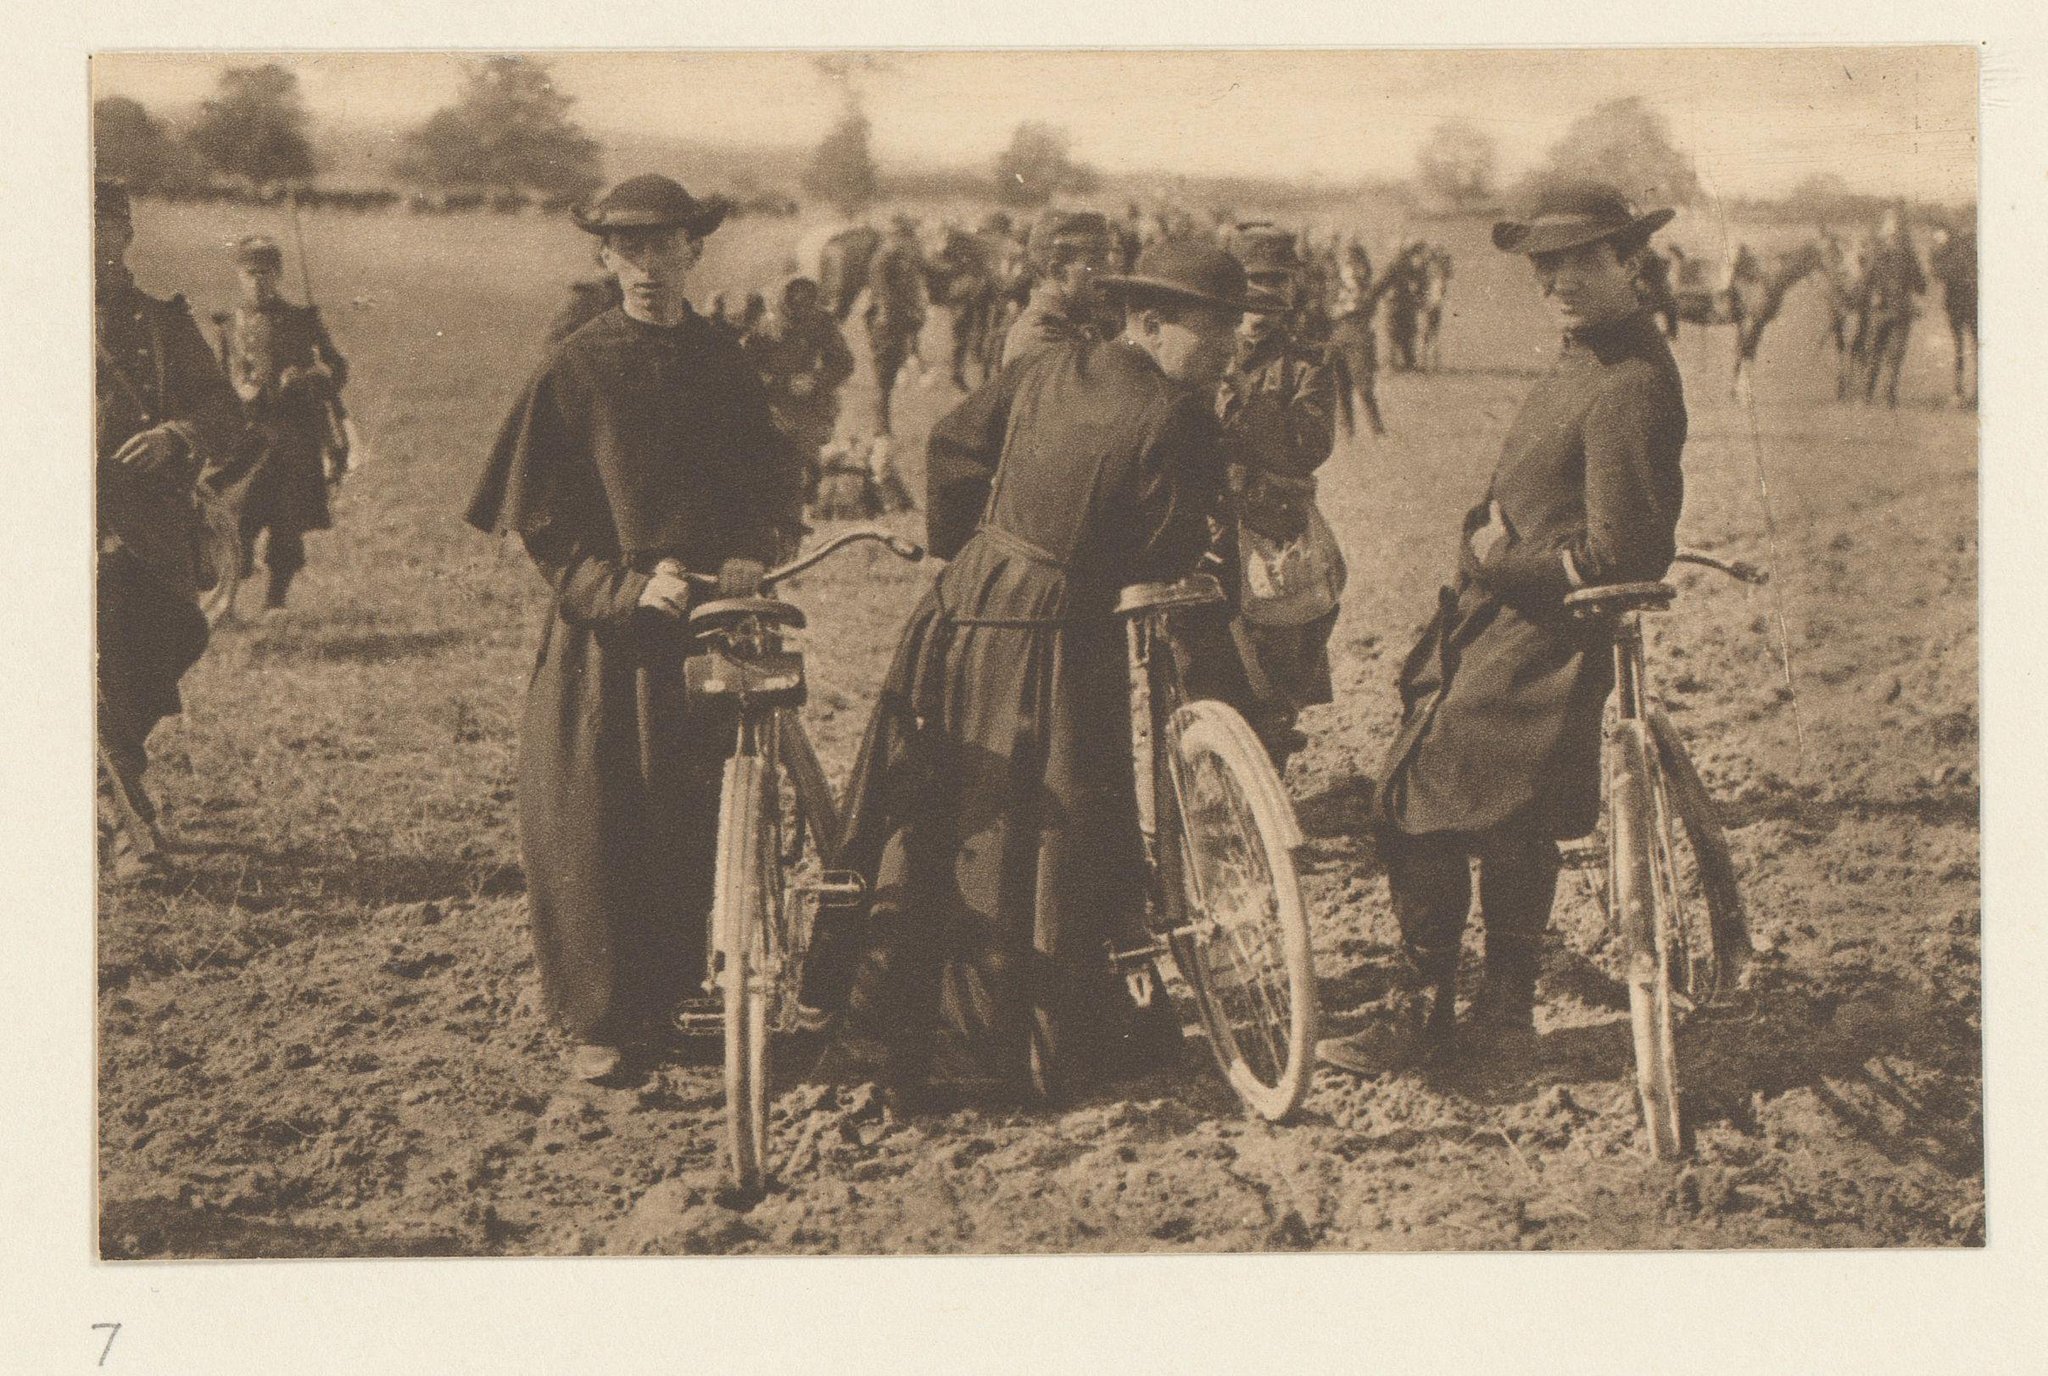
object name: ansichtkaart, prentbriefkaart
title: De Fransche Geestelijkheid geeft bewonderenswaardige blijken van heldenmoed en toewijding (...)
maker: sémaphore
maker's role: printer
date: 1915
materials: paper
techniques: photograph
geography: marseille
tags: religious care ~military service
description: Franse geestelijken met fietsen in de achterhoede. Onderdeel van de tweede serie van twaalf (acht aanwezig) prentbriefkaarten over de Eerste Wereldoorlog, 1915.